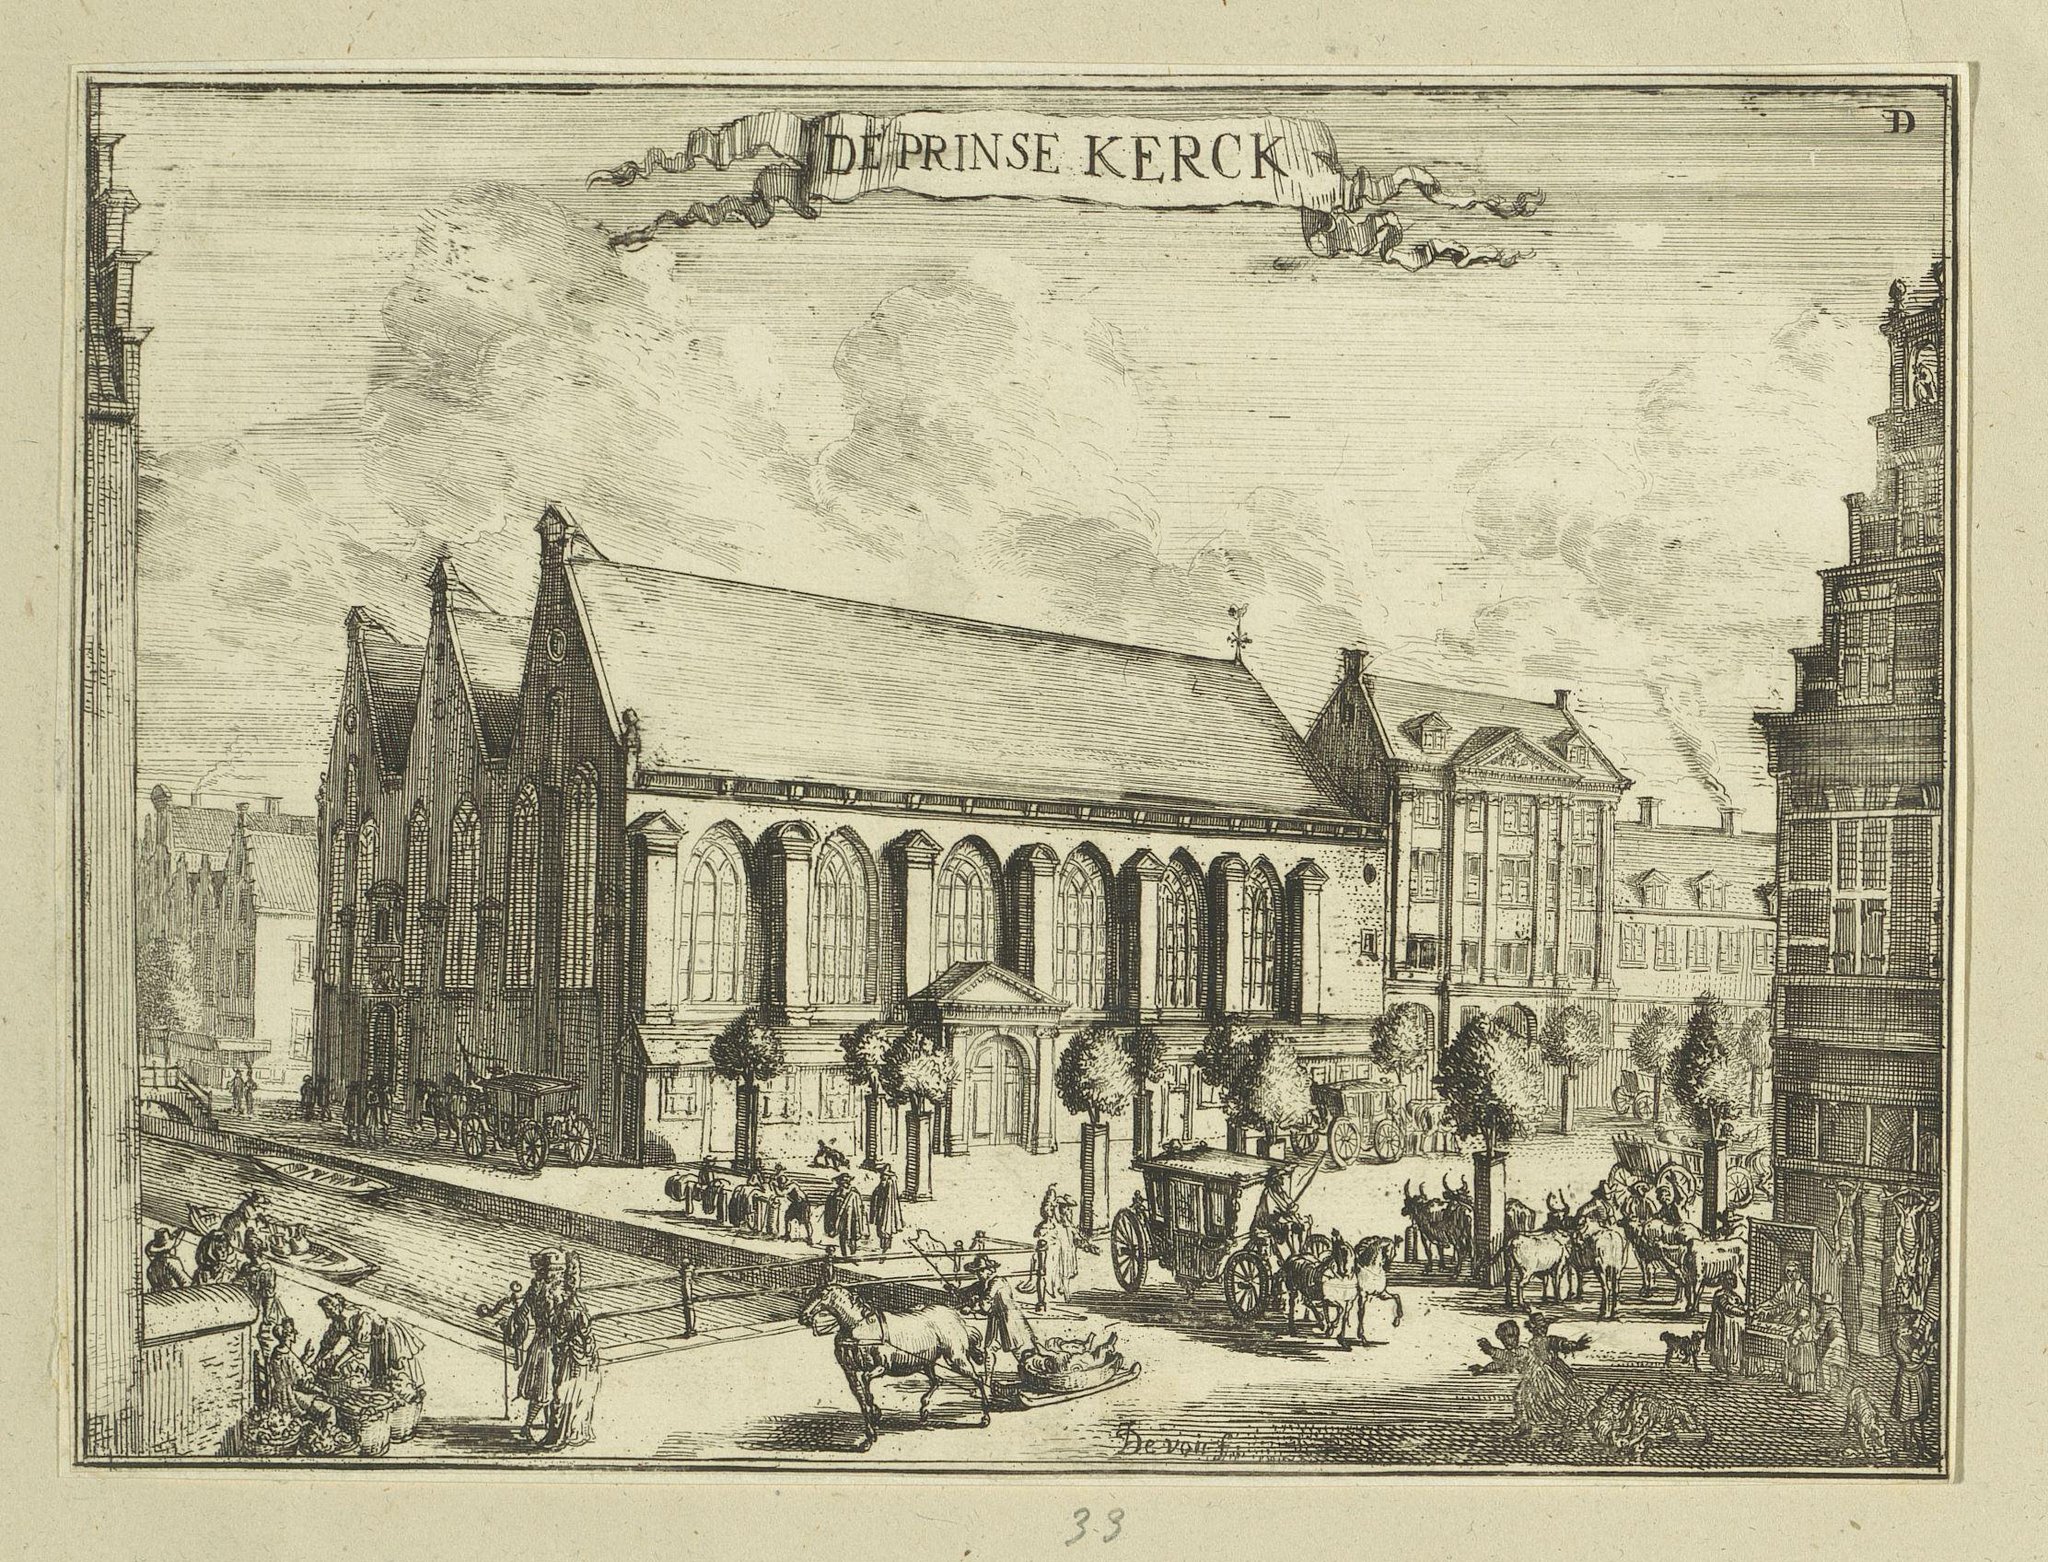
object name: print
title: Gezicht op de Prinsenkerk te Rotterdam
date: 1694-1695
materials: paper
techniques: engraving, etching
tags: church (exterior), canals, waters (in city), street (+ city(-scape) with figures, staffage)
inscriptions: collector's mark: Lugt 2228, collector's mark: Lugt 195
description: Prent oorspronkelijk gedrukt als onderdeel van de sierrand van 'Rotterdam met al syn gebouwen net op haer maet geteekent en gesneden', een wandkaart van Rotterdam, in prent gebracht door Romeyn de Hooghe en Johannes de Vouw. De rand om de plattegrond bestond uit wapenranden (langs de bovenkant en zijkanten), twaalf stadsgezichten (A-F langs de linker zijkant en G-M langs de rechter zijkant) en een stadsprofiel (langs de onderkant). Zie documentatie voor meer informatie. Zie ook RP-P-AO-13-87.